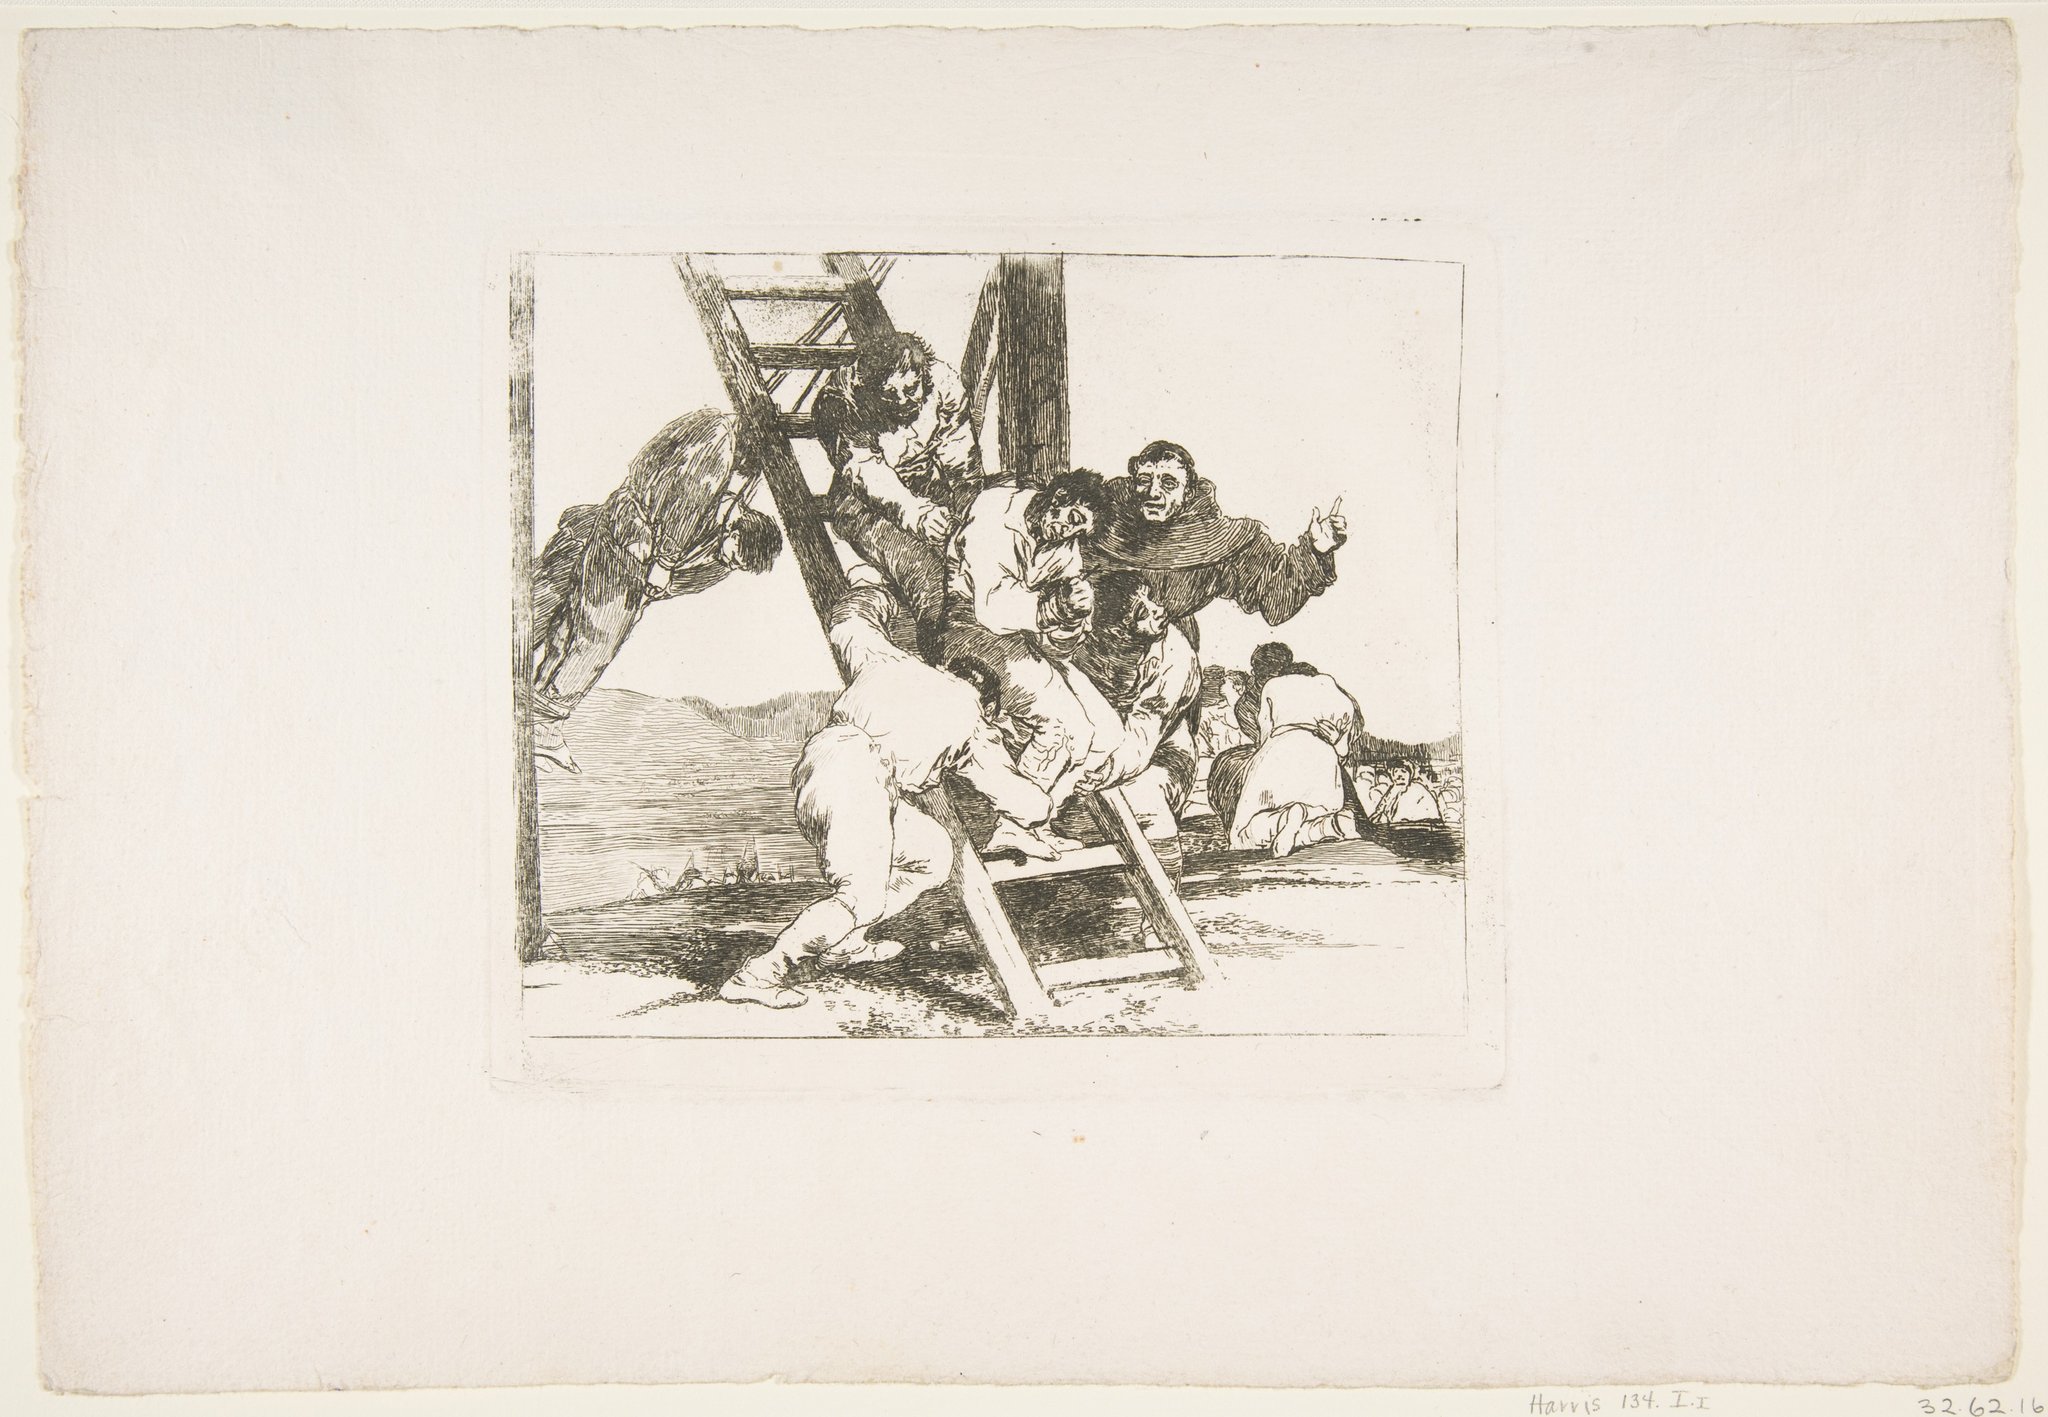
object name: print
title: Plate 14 from "The Disasters of War" (Los Desastres de la Guerra): 'It's a Hard Step!' (Duro es el paso!)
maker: goya (francisco de goya y lucientes)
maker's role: artist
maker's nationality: spanish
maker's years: 1746-1828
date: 1810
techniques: engraving, drypoint, etching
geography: spain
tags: suffering,men,ladders